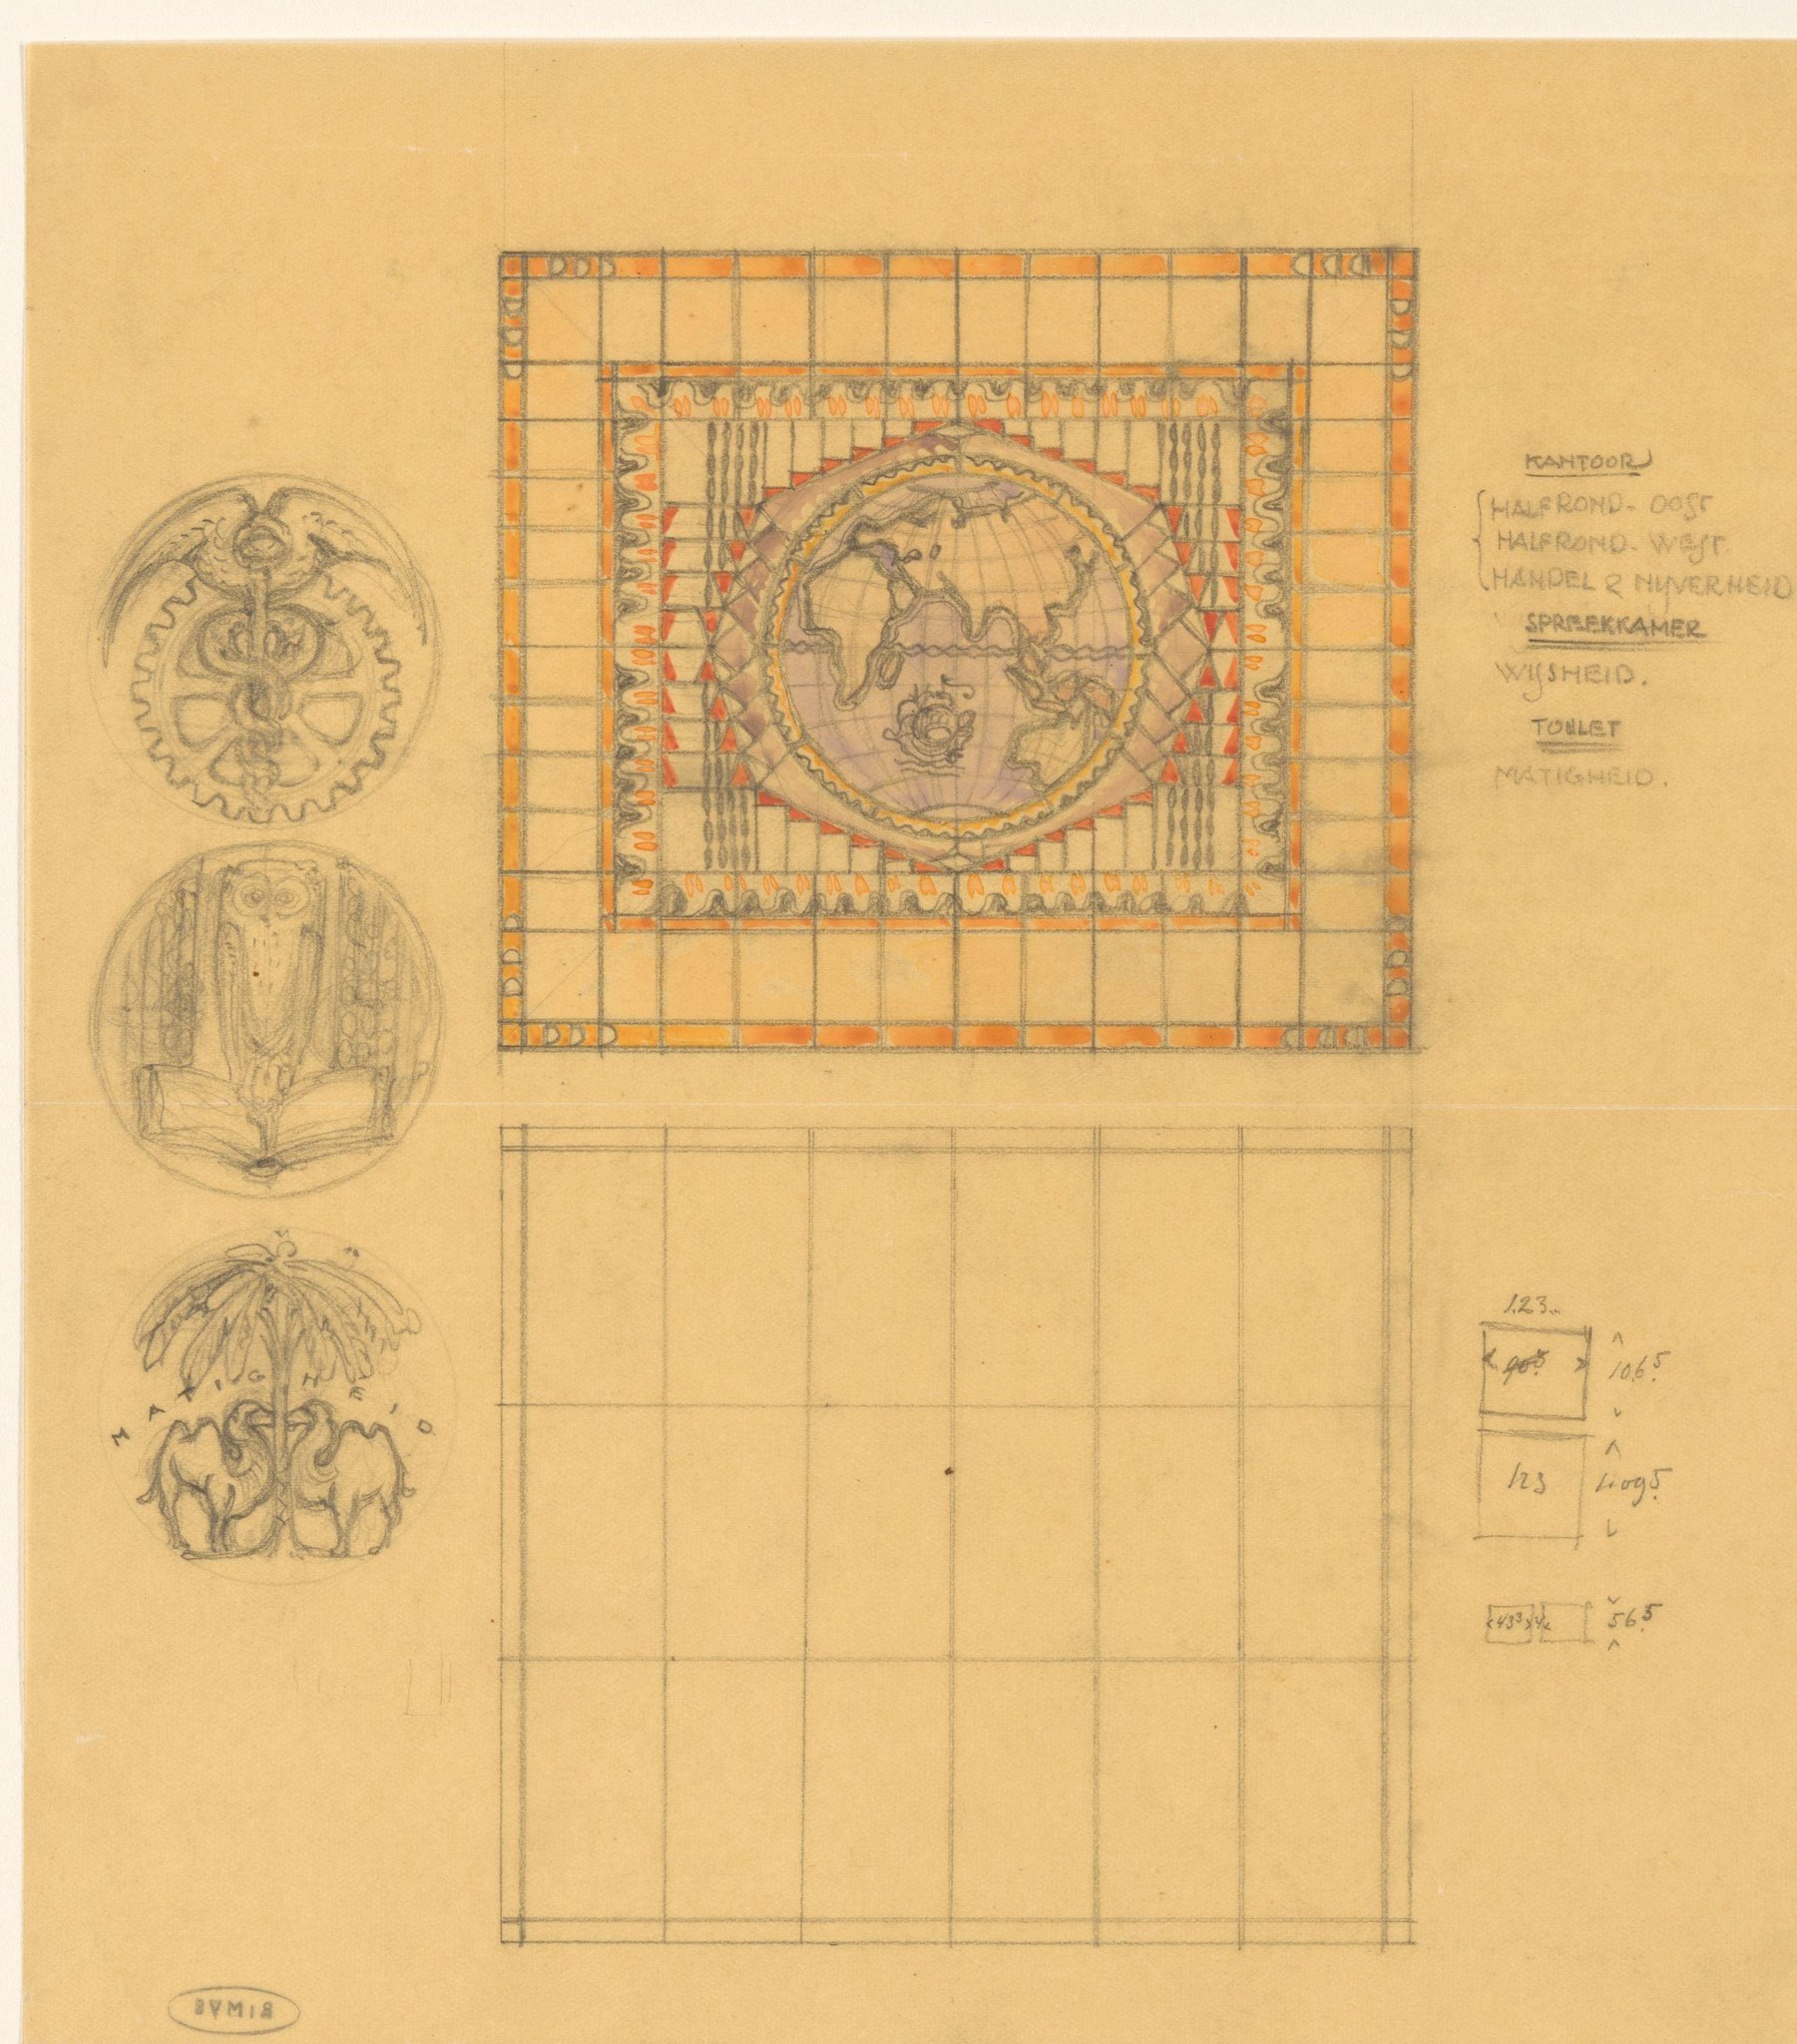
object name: drawing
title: Ontwerp voor een glas in loodraam met een wereldkaart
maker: Anonymous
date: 1907-1930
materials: pencil, paper, watercolor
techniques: brush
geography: amsterdam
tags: hoofed animals: camel, map of the world, owls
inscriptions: collector's mark: Lugt 2228a, annotation:, inscription: ‘KANTOOR/ HALFROND - OOGST ... WIJSHEID./ TOILET/ MATIGHEID.’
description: Ontwerp voor een rechthoekig glas in loodraam met in het midden een wereldkaart in een ronde vorm. Tevens drie andere allegorische ontwerpen die vermoedelijk op dezelfde wijze de ronde vorm van het venster moeten vullen, waaronder een voorstelling met een caduceus (Handel), een uil op een boek (Wijsheid) en twee kamelen bij een palm (Matigheid).